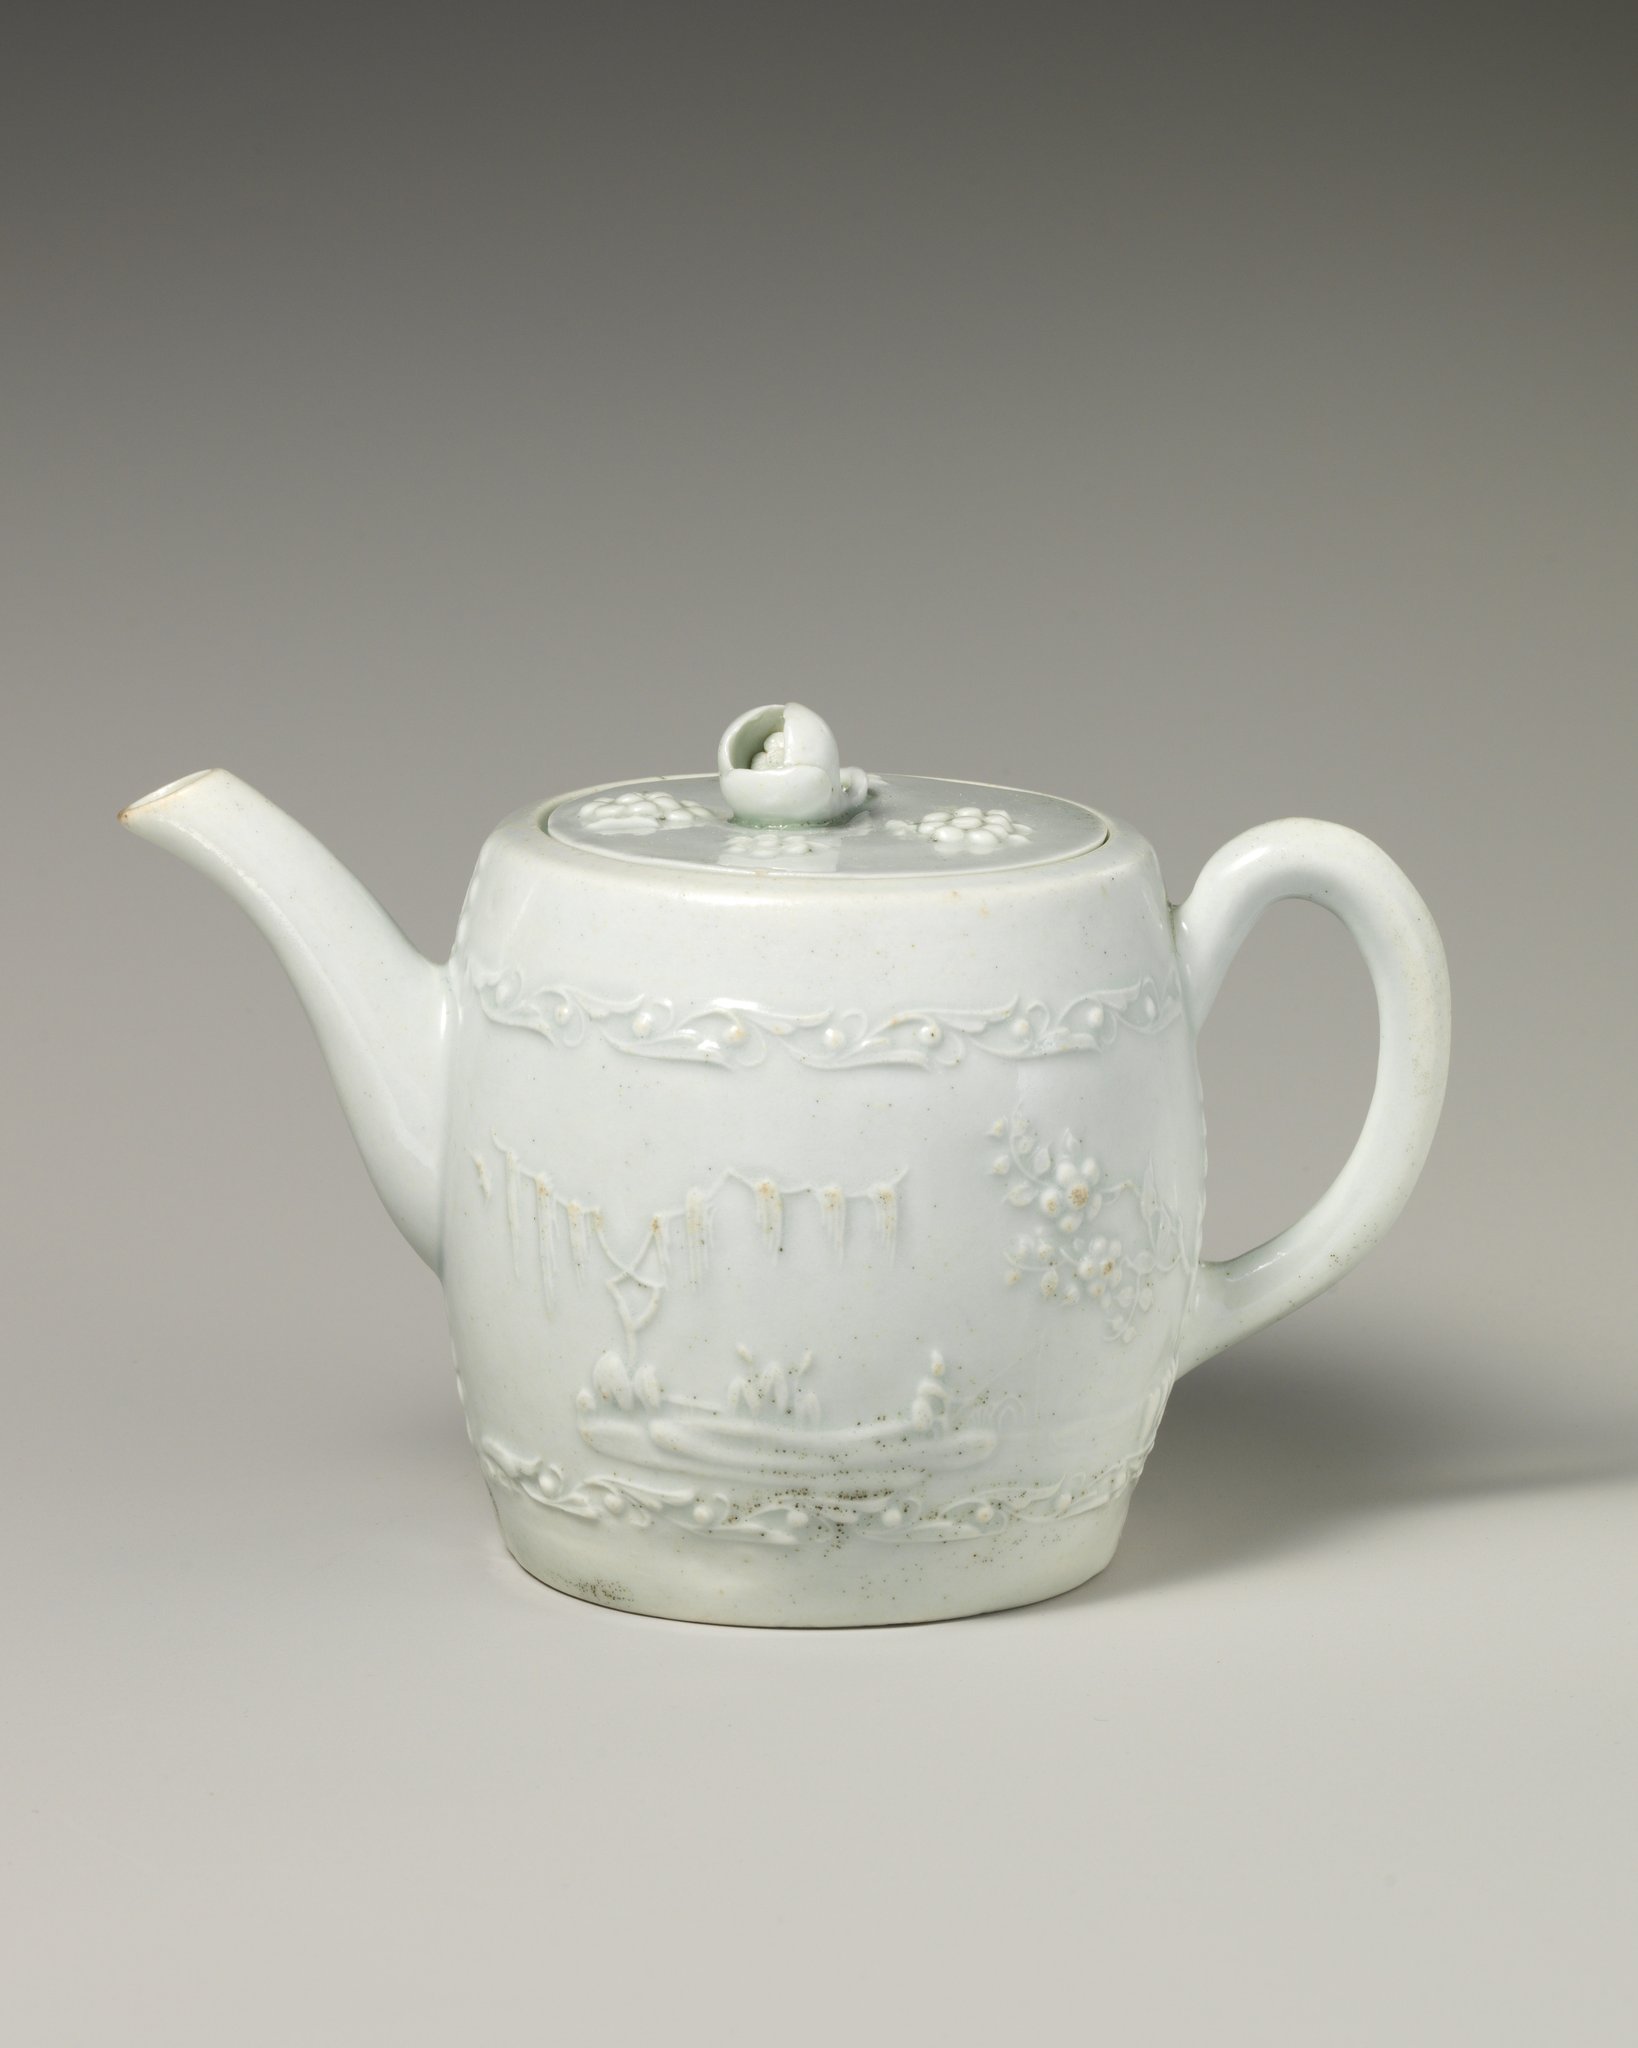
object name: teapot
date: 1701-1800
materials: soft paste porcelain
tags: flowers